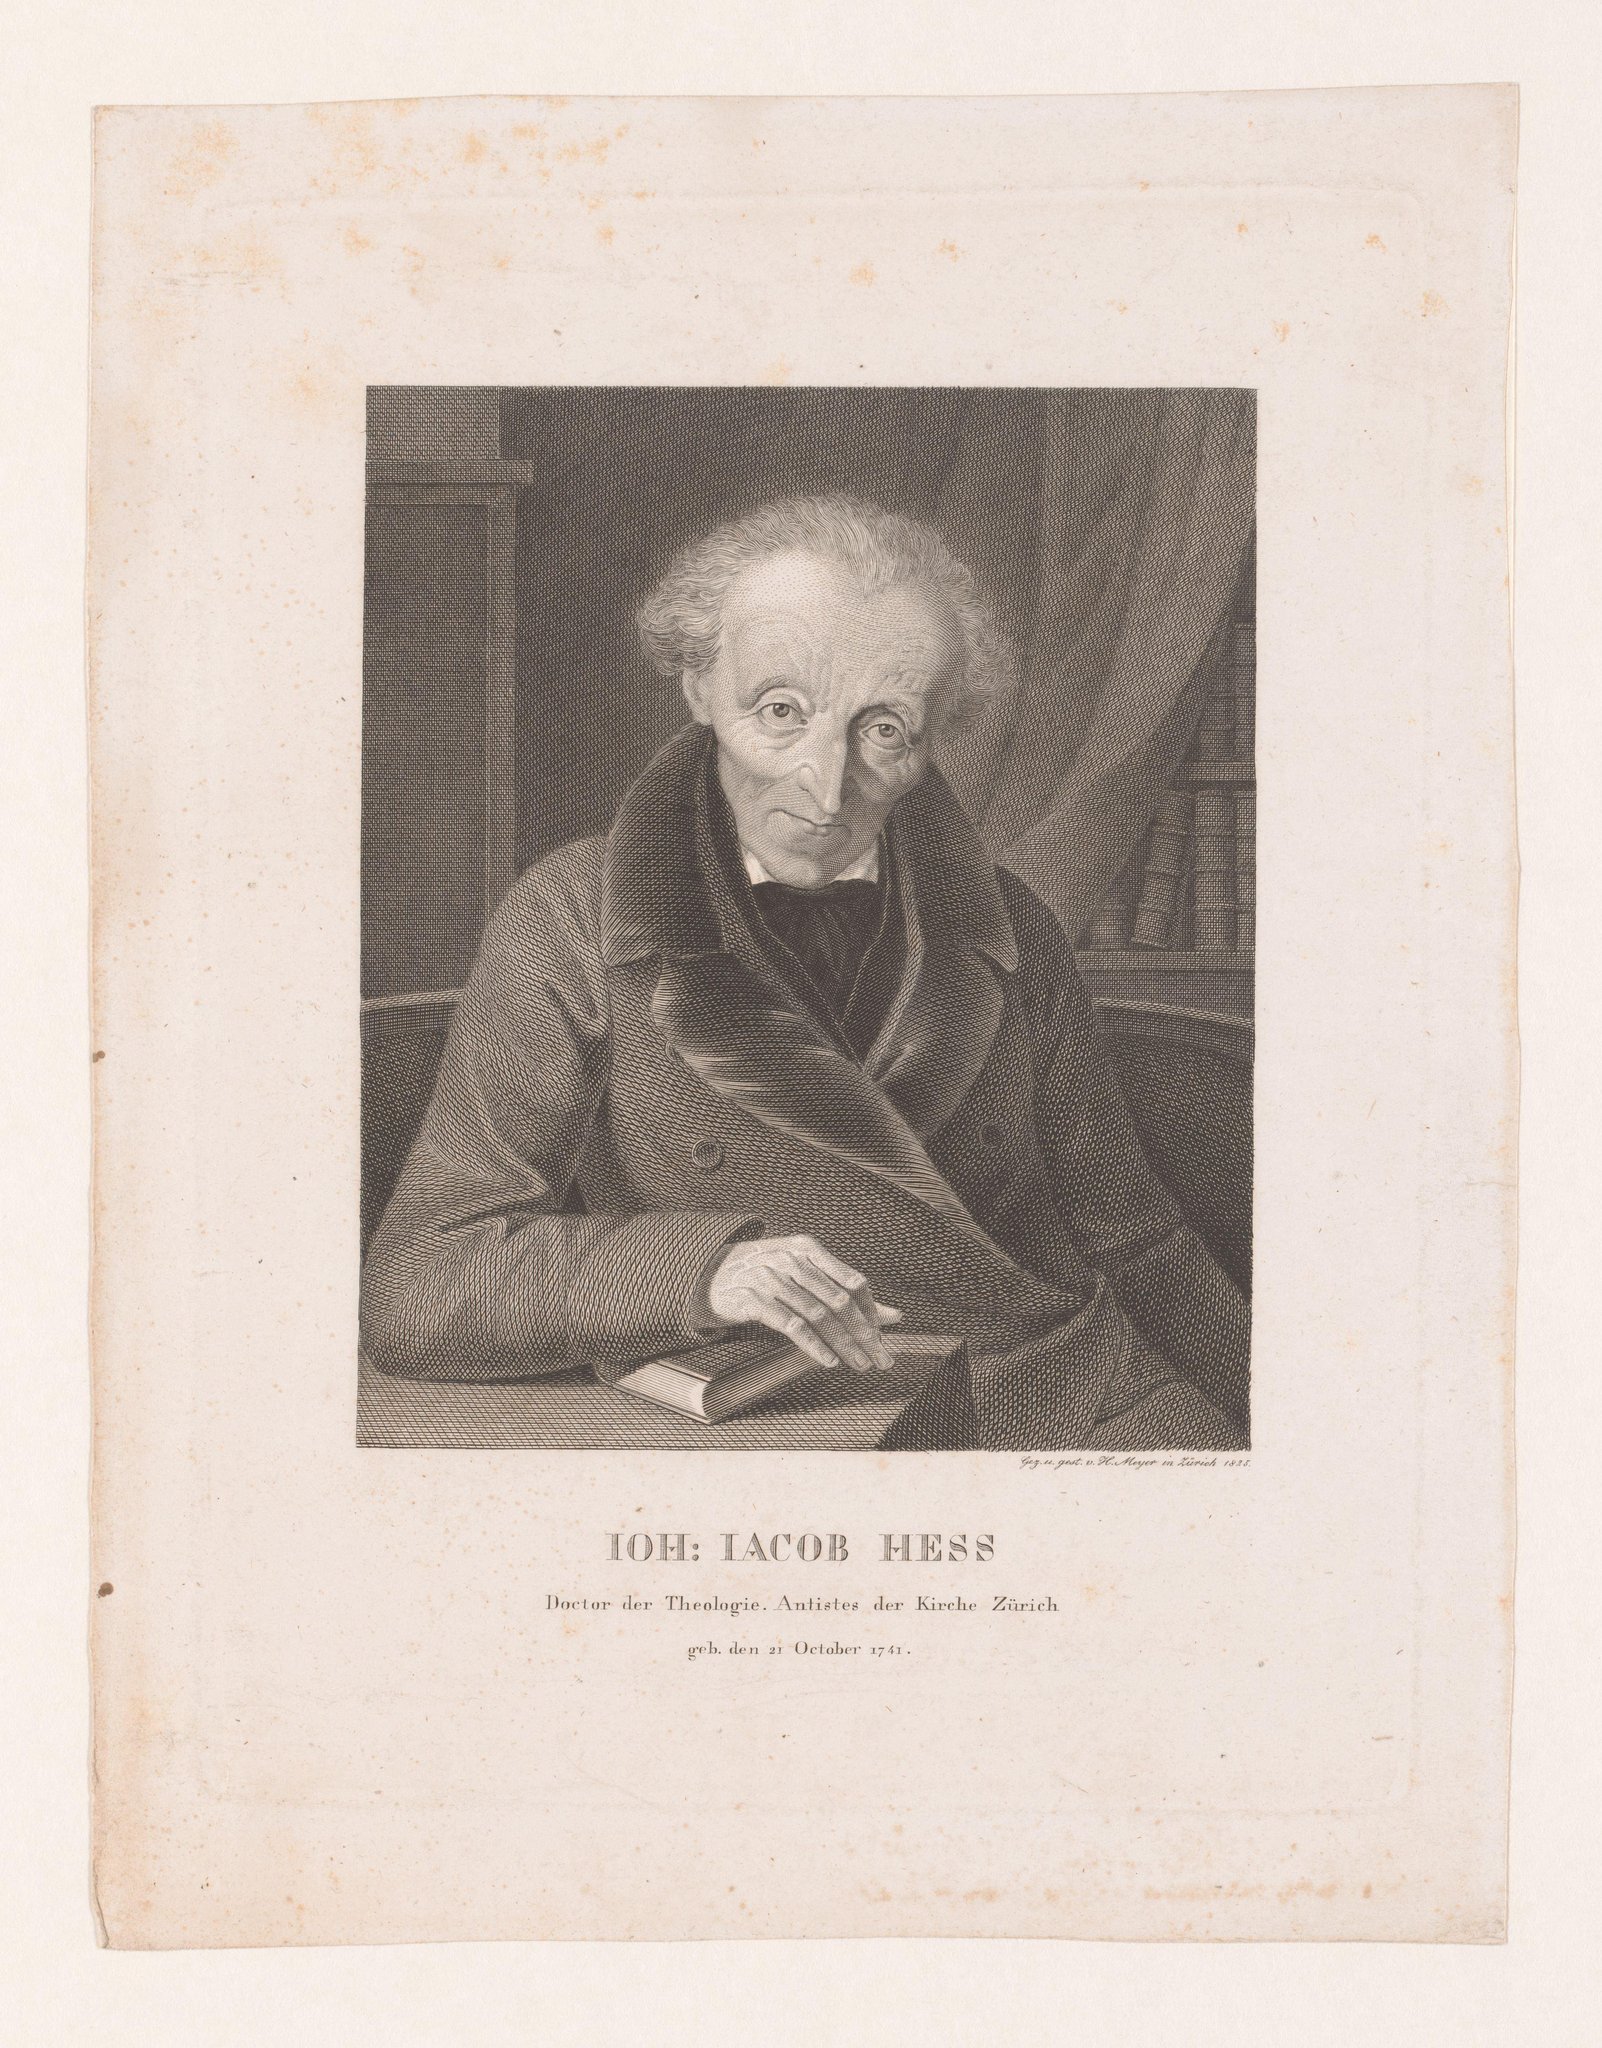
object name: print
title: Portret van Johann Jakob Hess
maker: heinrich meyer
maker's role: print maker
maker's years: 1802-1877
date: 1812-1877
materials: paper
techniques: engraving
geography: zurich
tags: bookshelves, historical persons, book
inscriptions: collector's mark: Lugt 2228